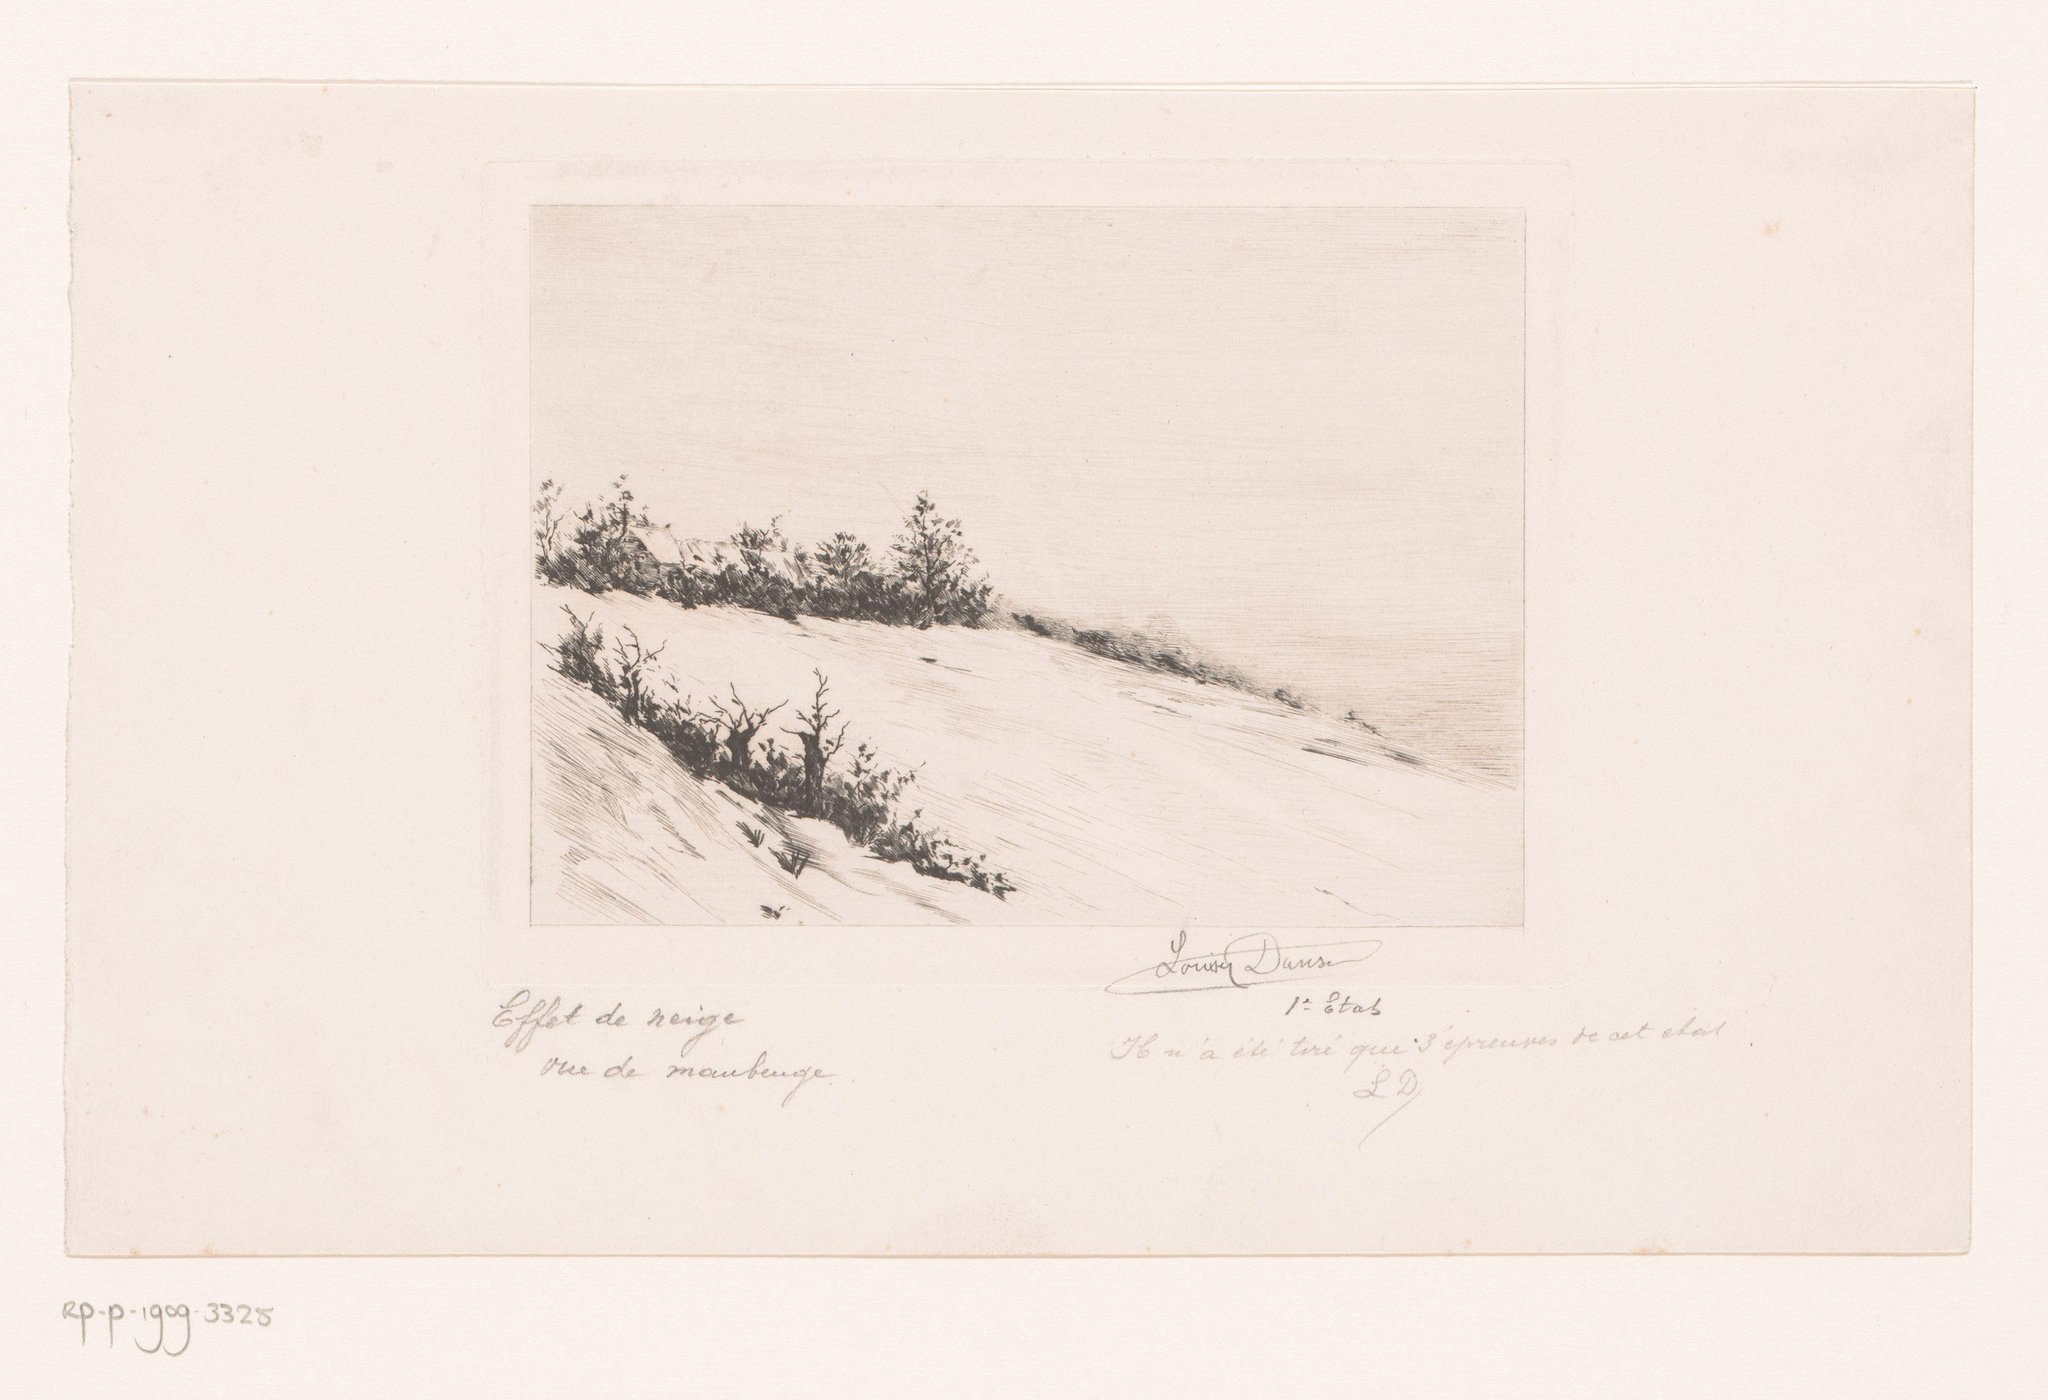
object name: print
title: Effet de neige, vue de Maubeuge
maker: louise danse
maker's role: painter, print maker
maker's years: 1867-1948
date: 1877-1909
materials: paper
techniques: drypoint, etching, intaglio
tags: snow, farm or solitary house in landscape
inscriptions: annotation: ‘1e Etat; Il n'a été tiré que 3 épreuves de cet etat’, collector's mark: Lugt 2228